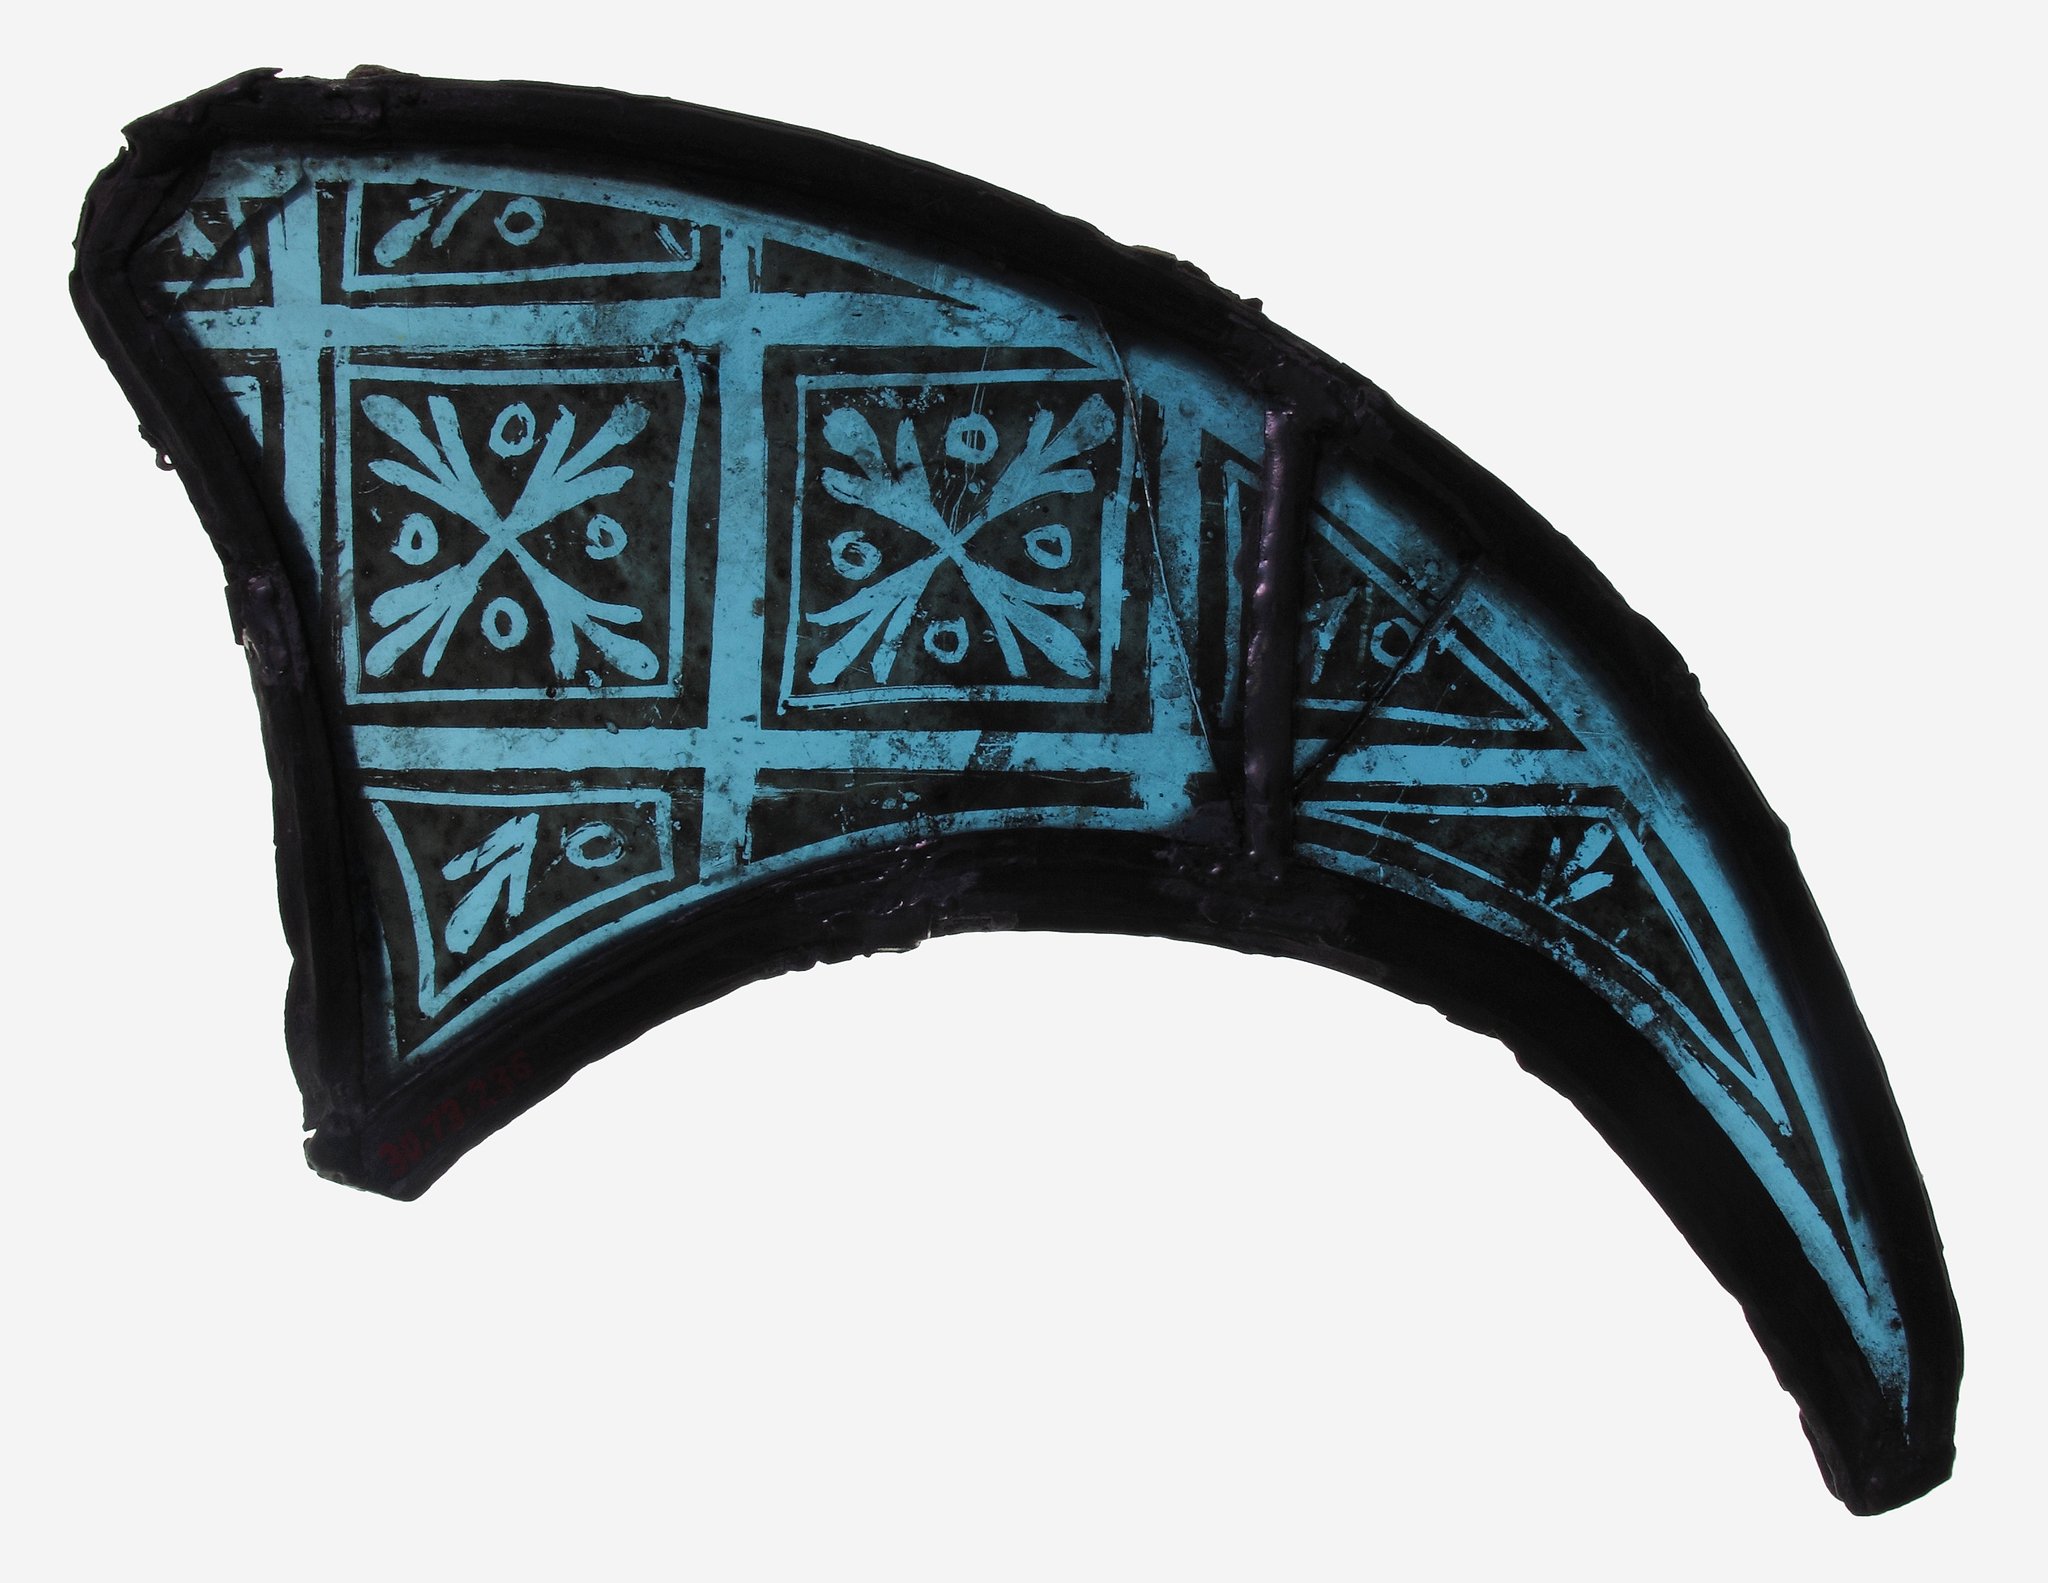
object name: fragment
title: Glass Fragment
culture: european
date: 1201-1400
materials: glass, metal